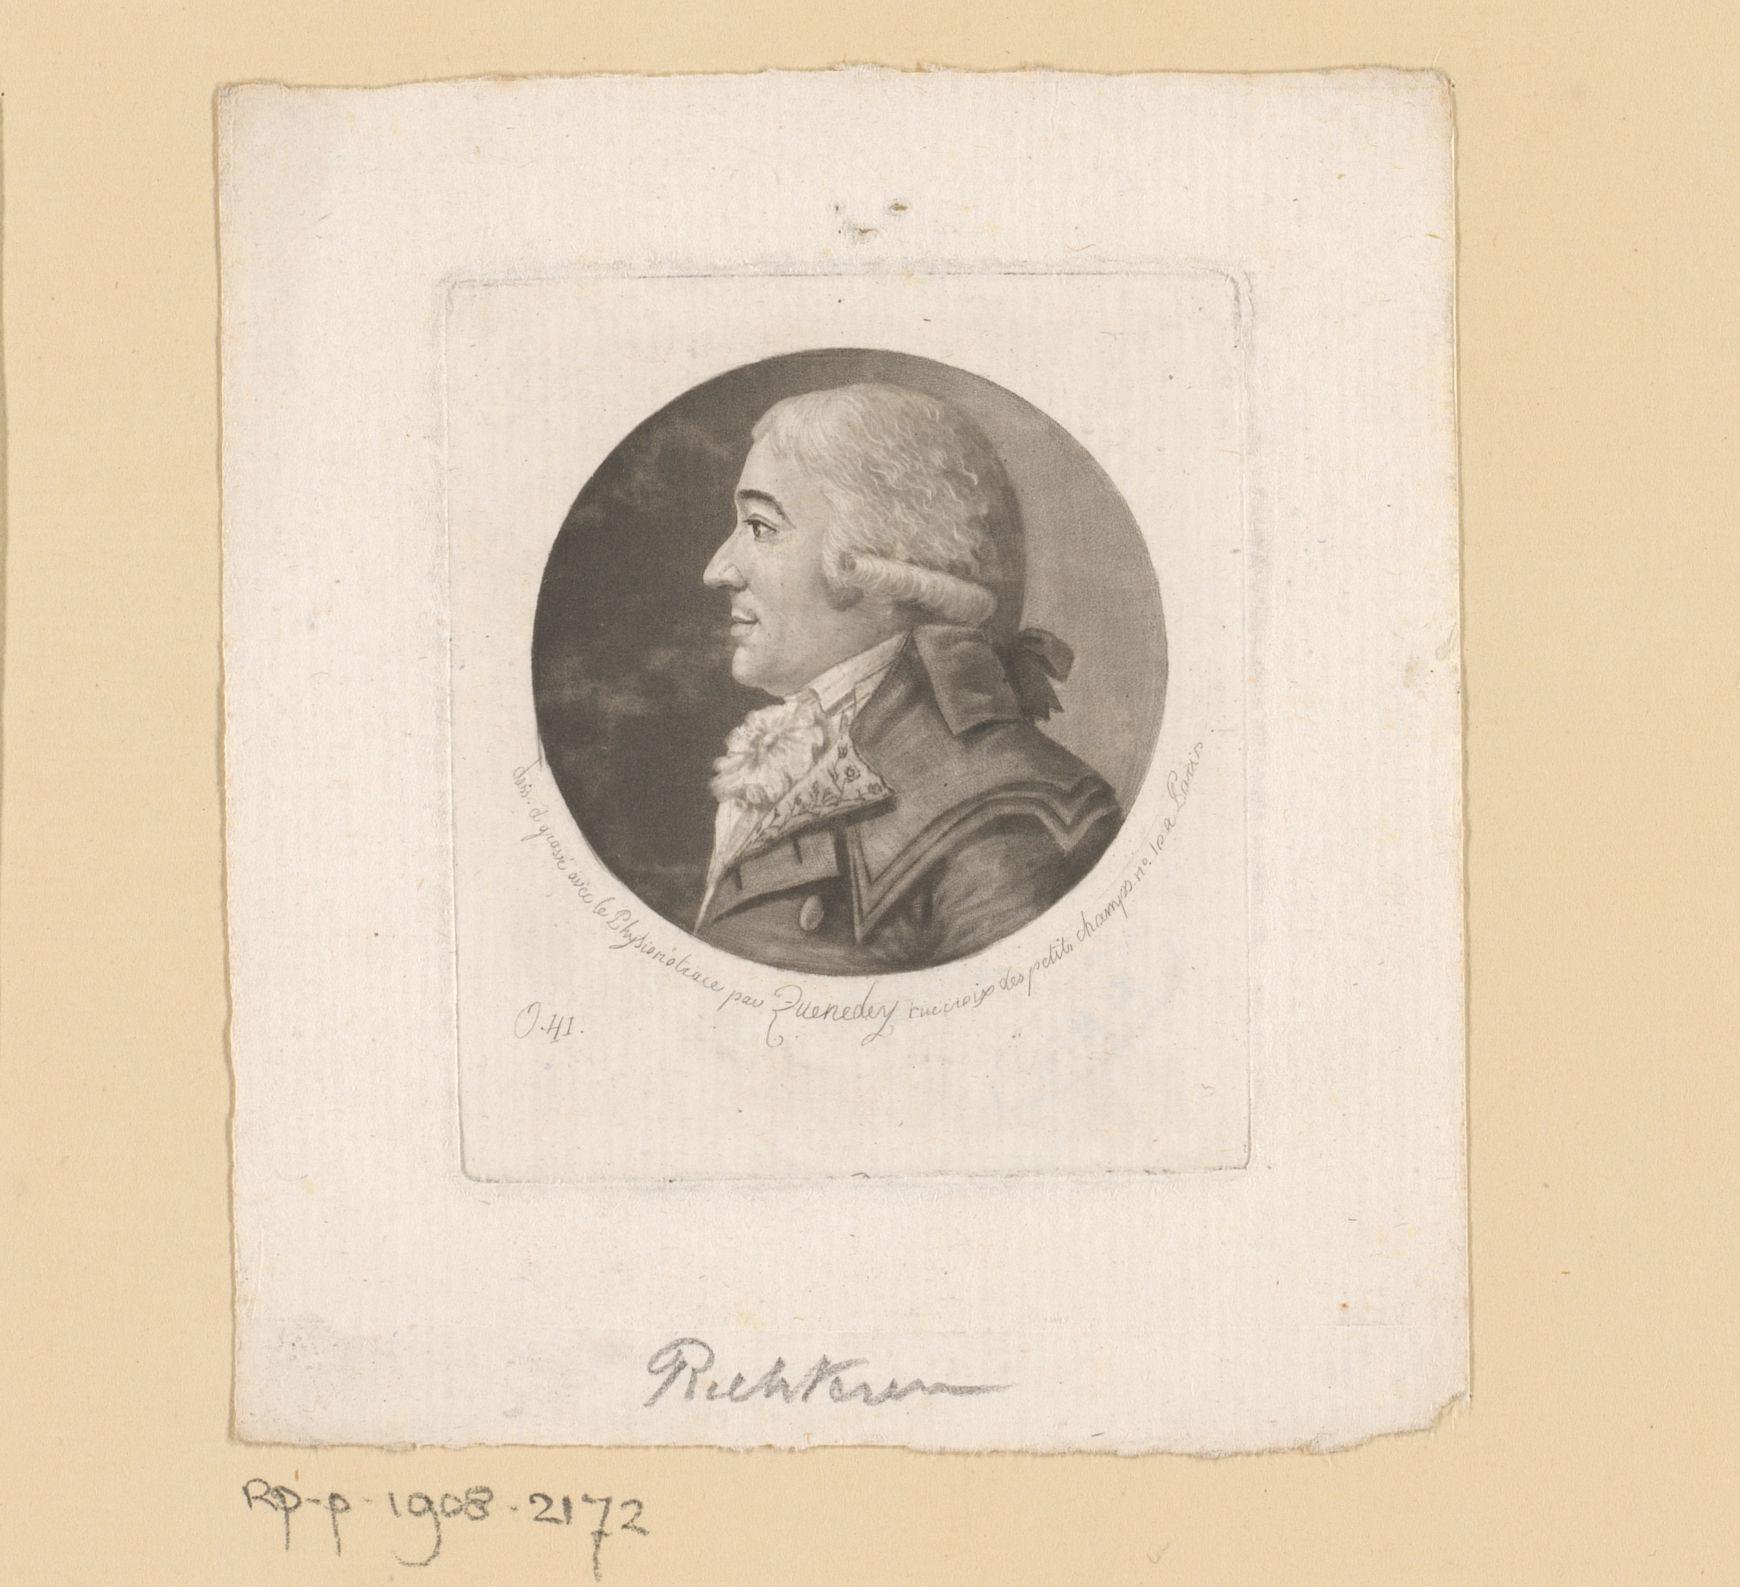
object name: physionotrace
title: Portret van een man uit het adellijk geslacht Van Rechteren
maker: edme quenedey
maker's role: print maker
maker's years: 1756-1830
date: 1785-1830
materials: paper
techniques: aquatint, etching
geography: paris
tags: silhouette-apparatus, 'physionotrace', historical persons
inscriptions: collector's mark: Lugt 2228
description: Deze prent heeft het nummer O.41 in het fonds van Quenedey.